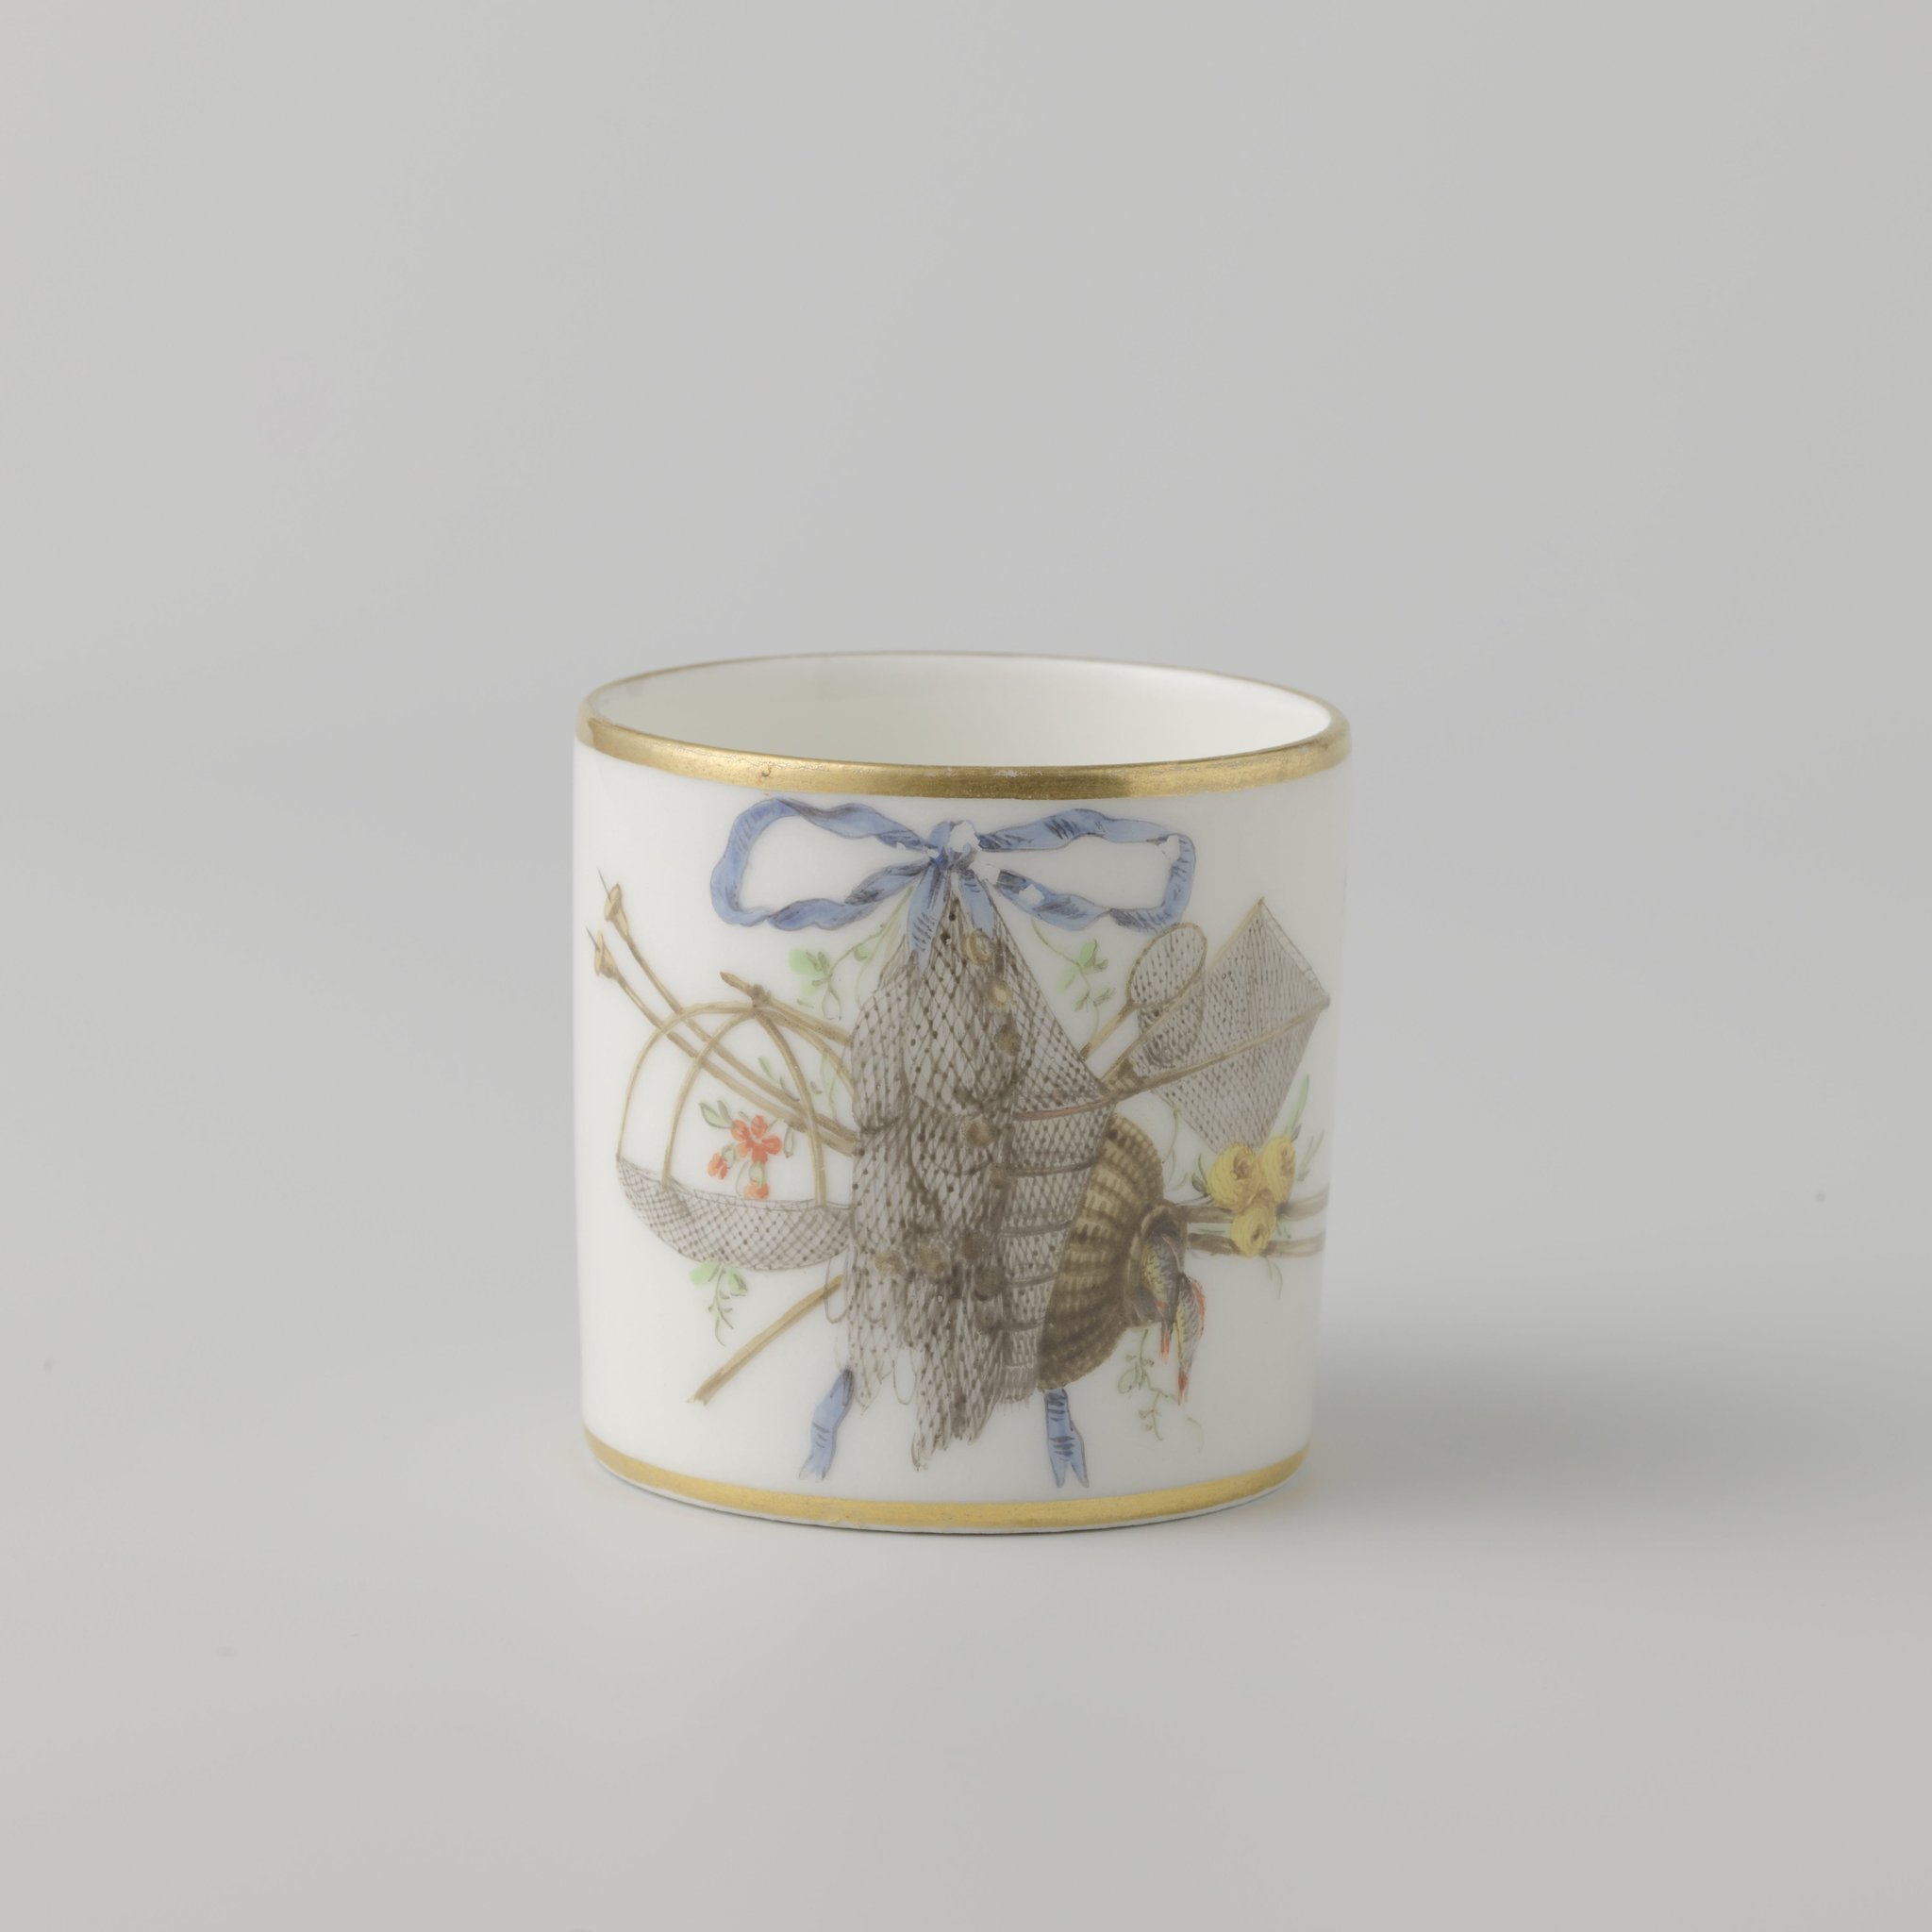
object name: cup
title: Theekop met decoratie van trofeeën aan gestrikte linten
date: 1809-1814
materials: porcelain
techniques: painted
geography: nieuwer-amstel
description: Theeservies bestaande uit een theepot, een suikerpot, een spoelkom en twaalf koppen en schotels veelkleurig beschilderd met trofeeën hangend aan blauwe strikken. De trofeeën hebben betrekking op diverse beroepen. Gemerkt in zwart: Amstel (de suikerpot Amstel N. 805 en ingegrift A). Verschillende ingegrifte merken in de koppen en schotels.